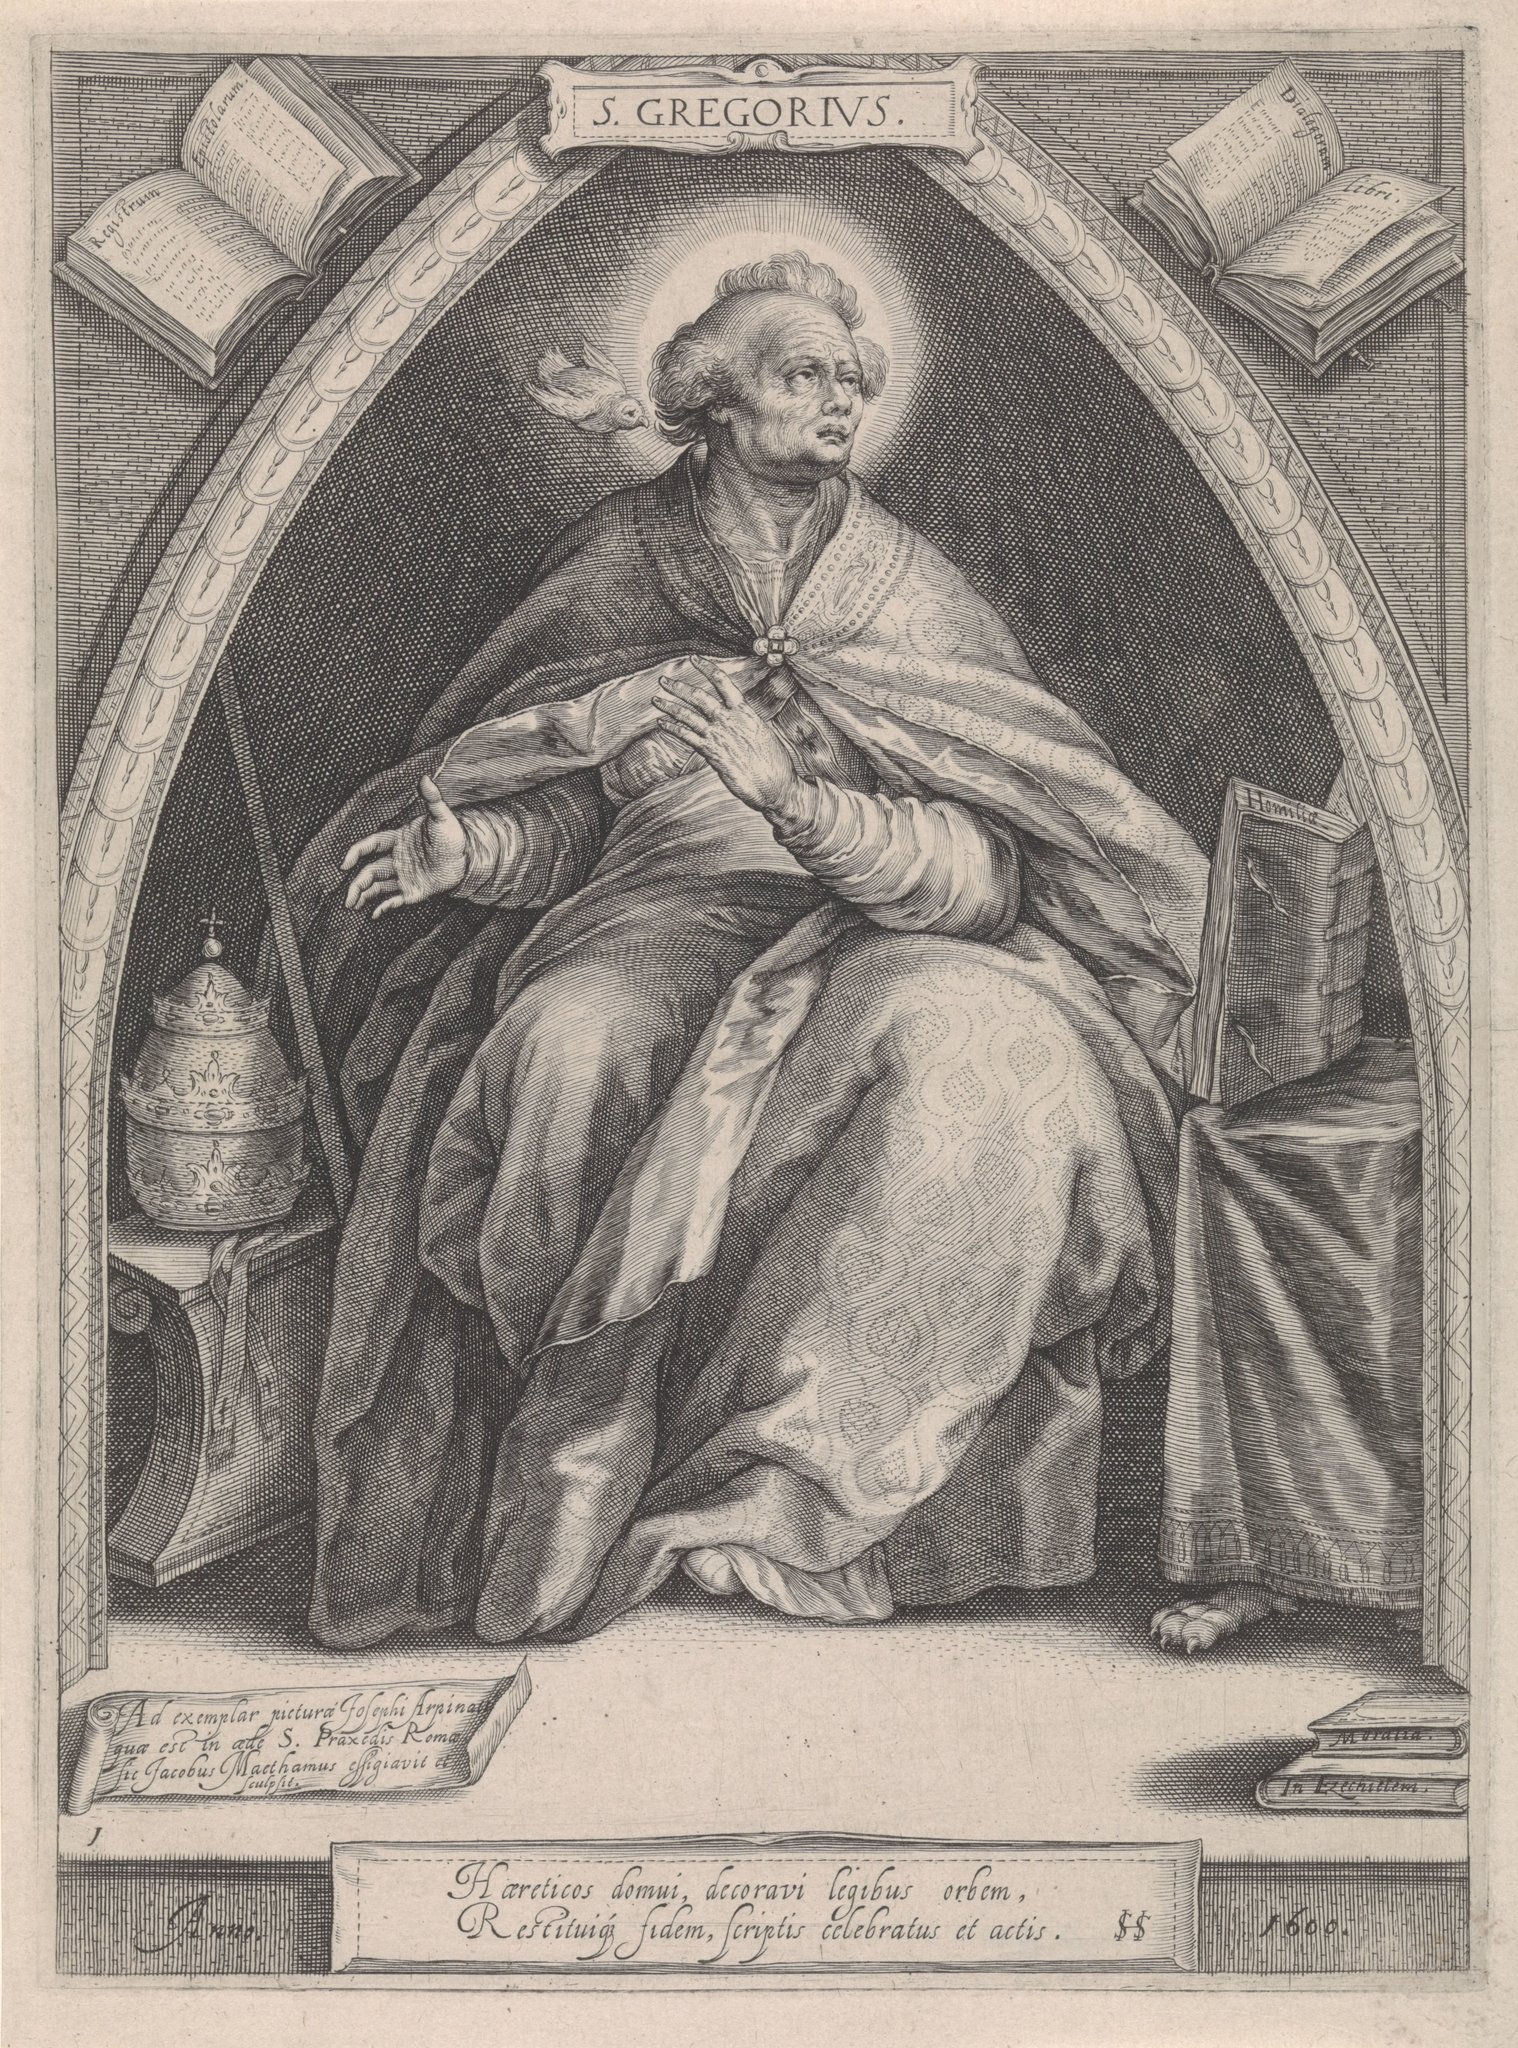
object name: print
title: H. Gregorius als kerkvader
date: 1600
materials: paper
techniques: engraving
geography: haarlem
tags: st. gregory the great as doctor of the latin church, with book, pen, and dove (divine inspiration)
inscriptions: collector's mark: Lugt 240